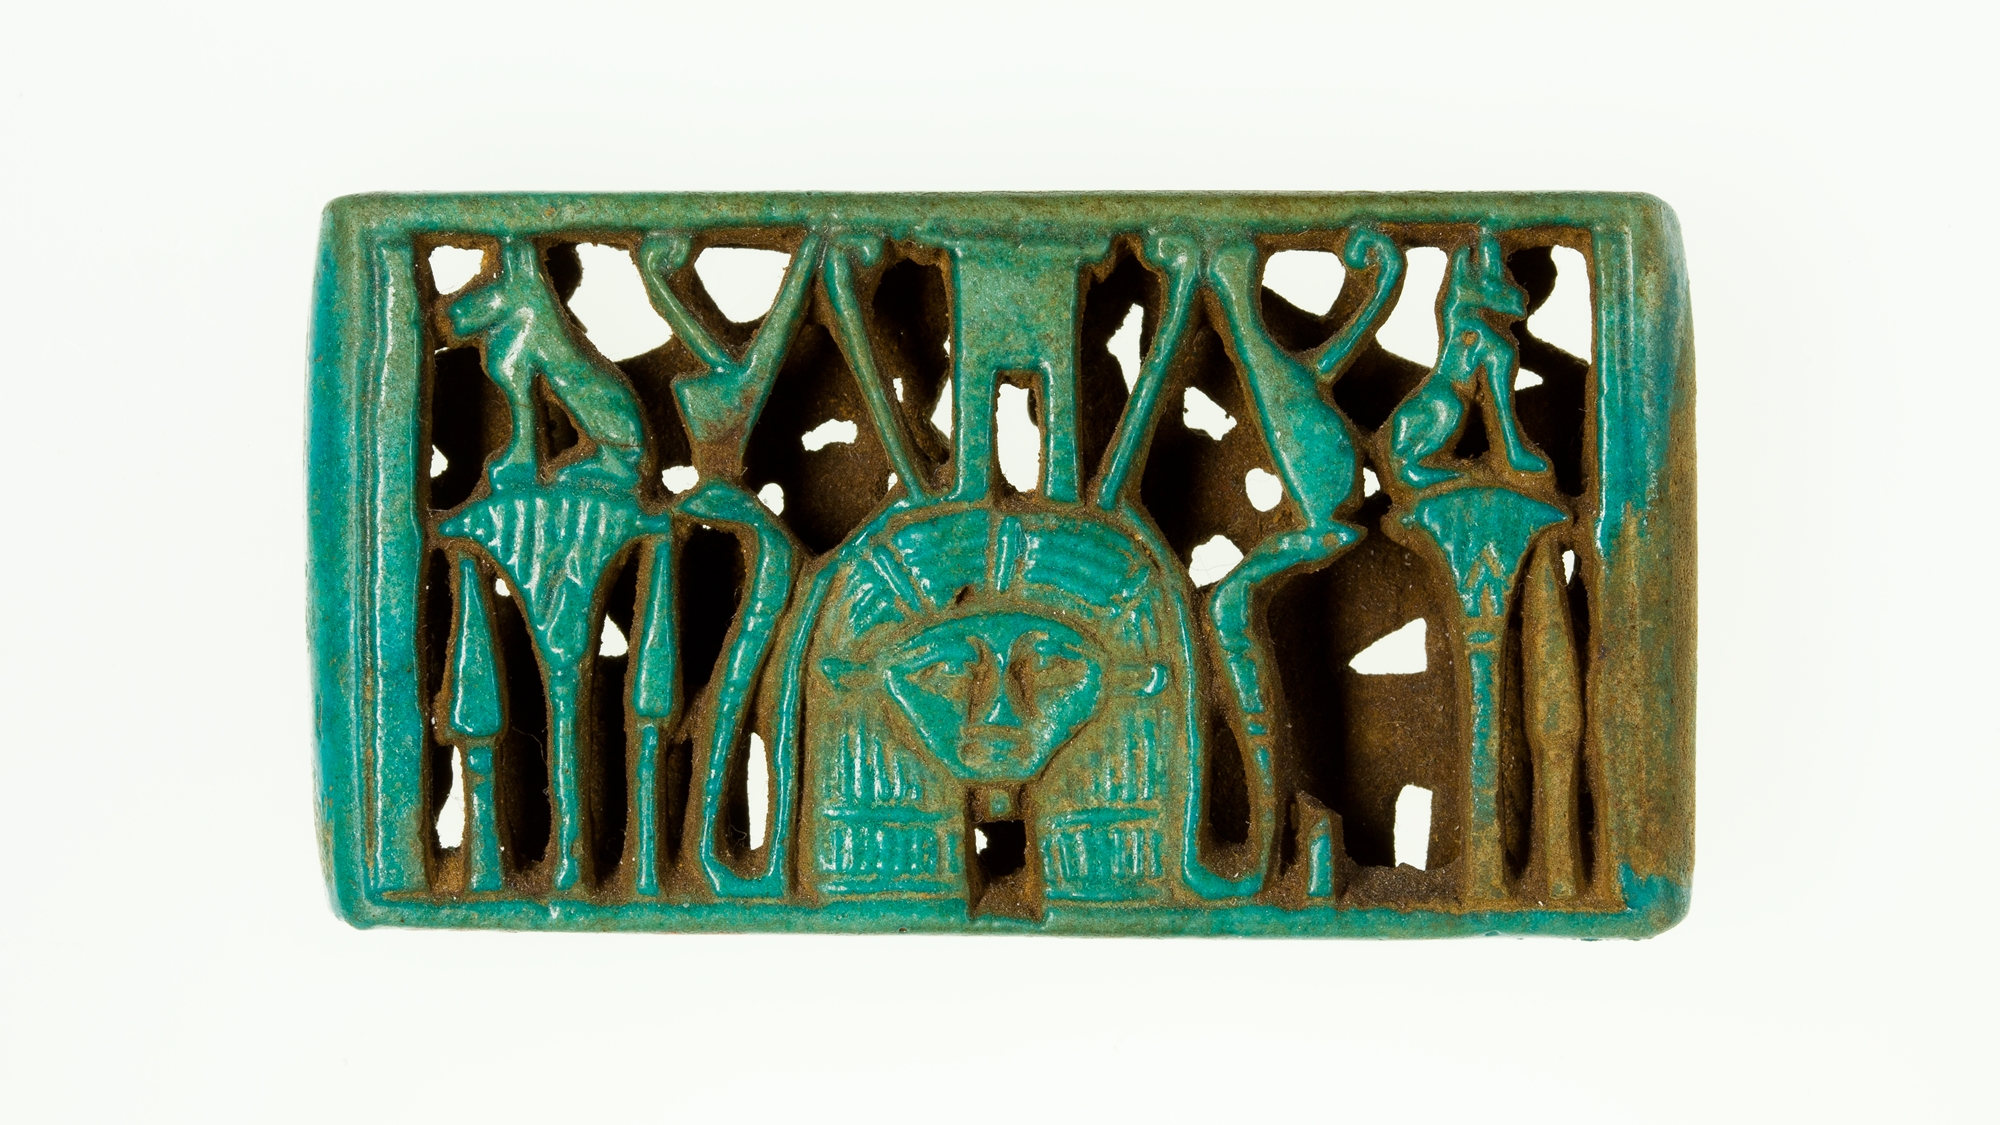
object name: spacer with hathor head, cobra and cat on marsh plant in openwork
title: Spacer with Hathor head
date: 1070-664 BCE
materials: faience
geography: egypt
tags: hathor,cats,serpents